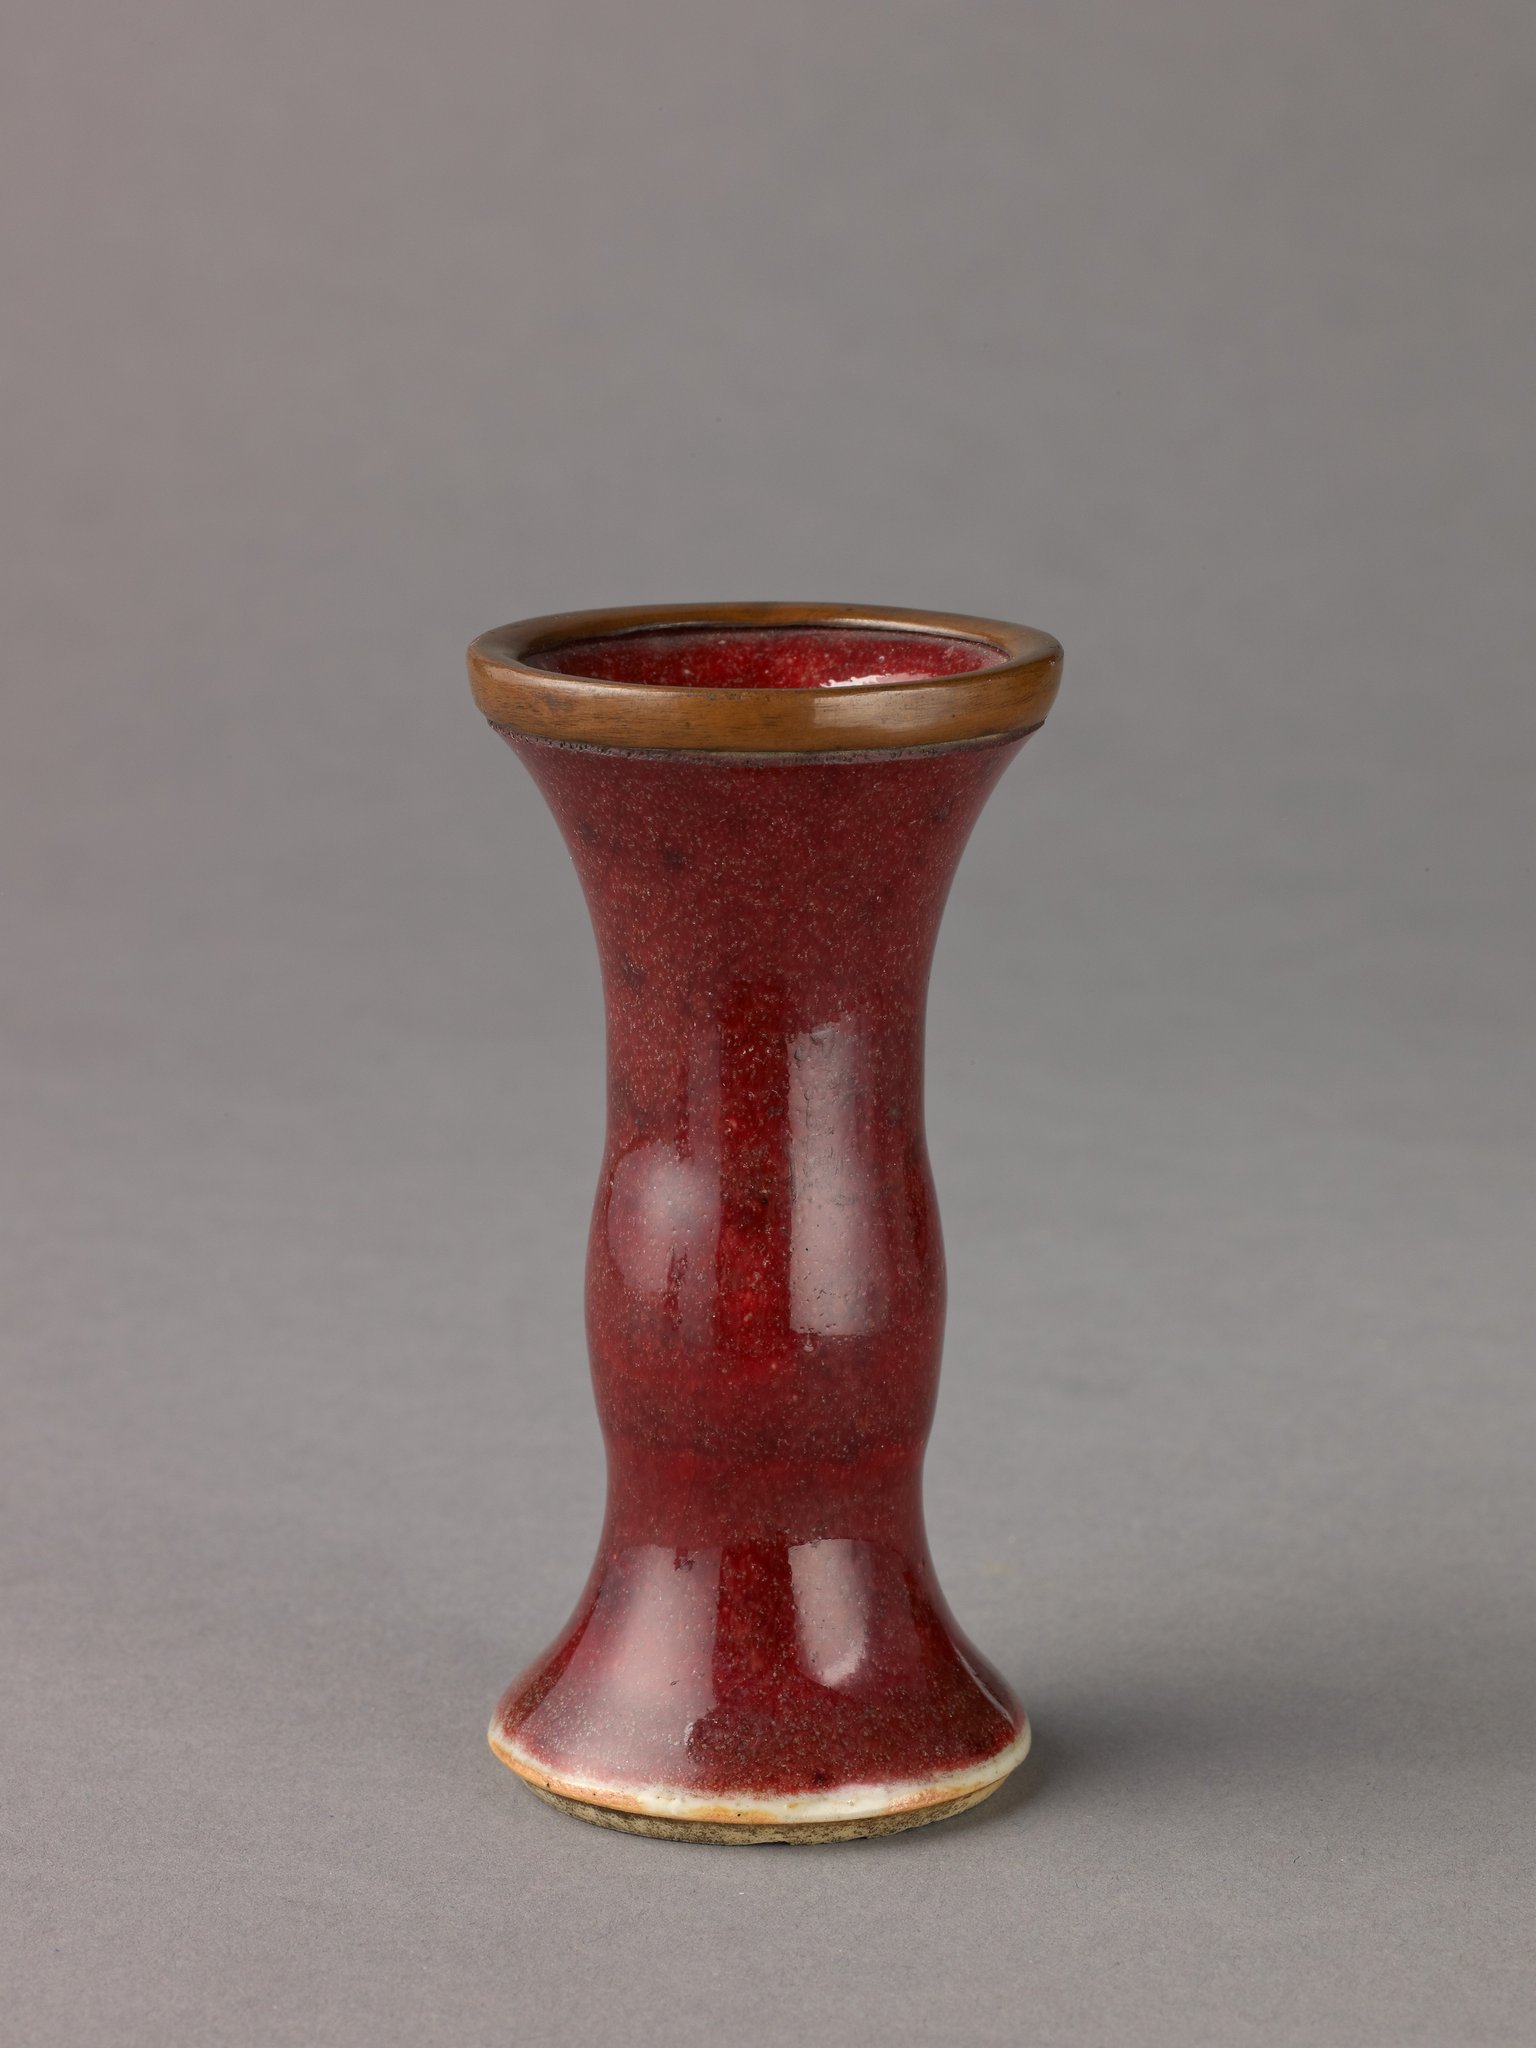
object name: vase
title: Small vase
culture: chinese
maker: chinese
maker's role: artist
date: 1801-1900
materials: glaze, porcelain